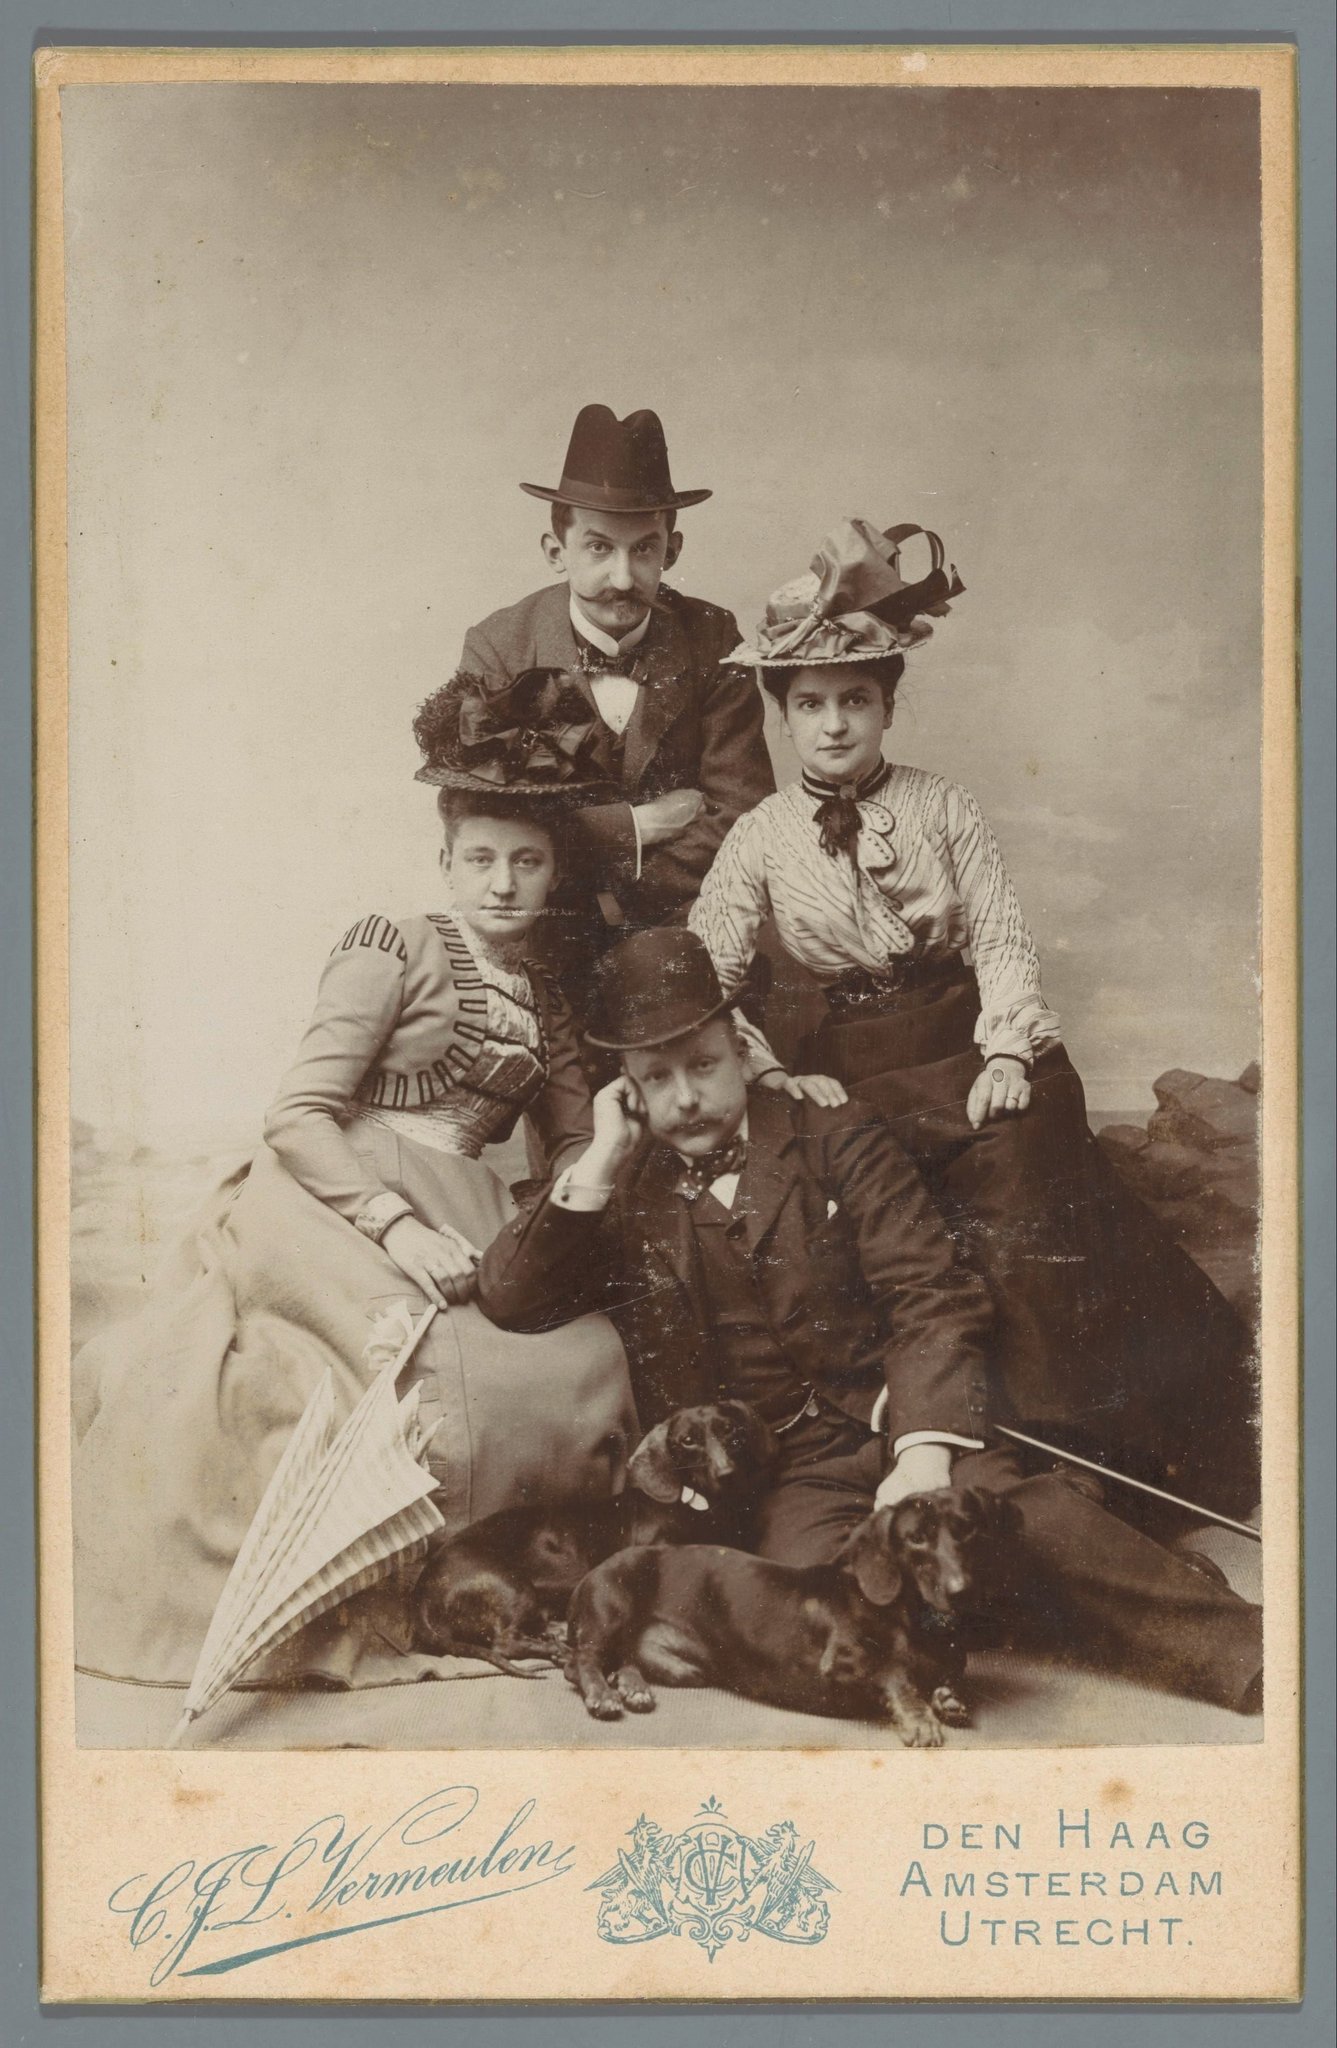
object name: cabinet photograph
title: Studioportret van vier onbekende mannen en vrouwen met twee teckels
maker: cornelis johannes lodewicus vermeulen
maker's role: fotograaf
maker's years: 1861-1936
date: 1895-1910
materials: cardboard, photographic support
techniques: gelatin silver print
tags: dog, anonymous historical persons portrayed in a group, in a group-portrait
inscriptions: inscription: ‘C.J.L. Vermeulen (...) Telephoon No. 750.’